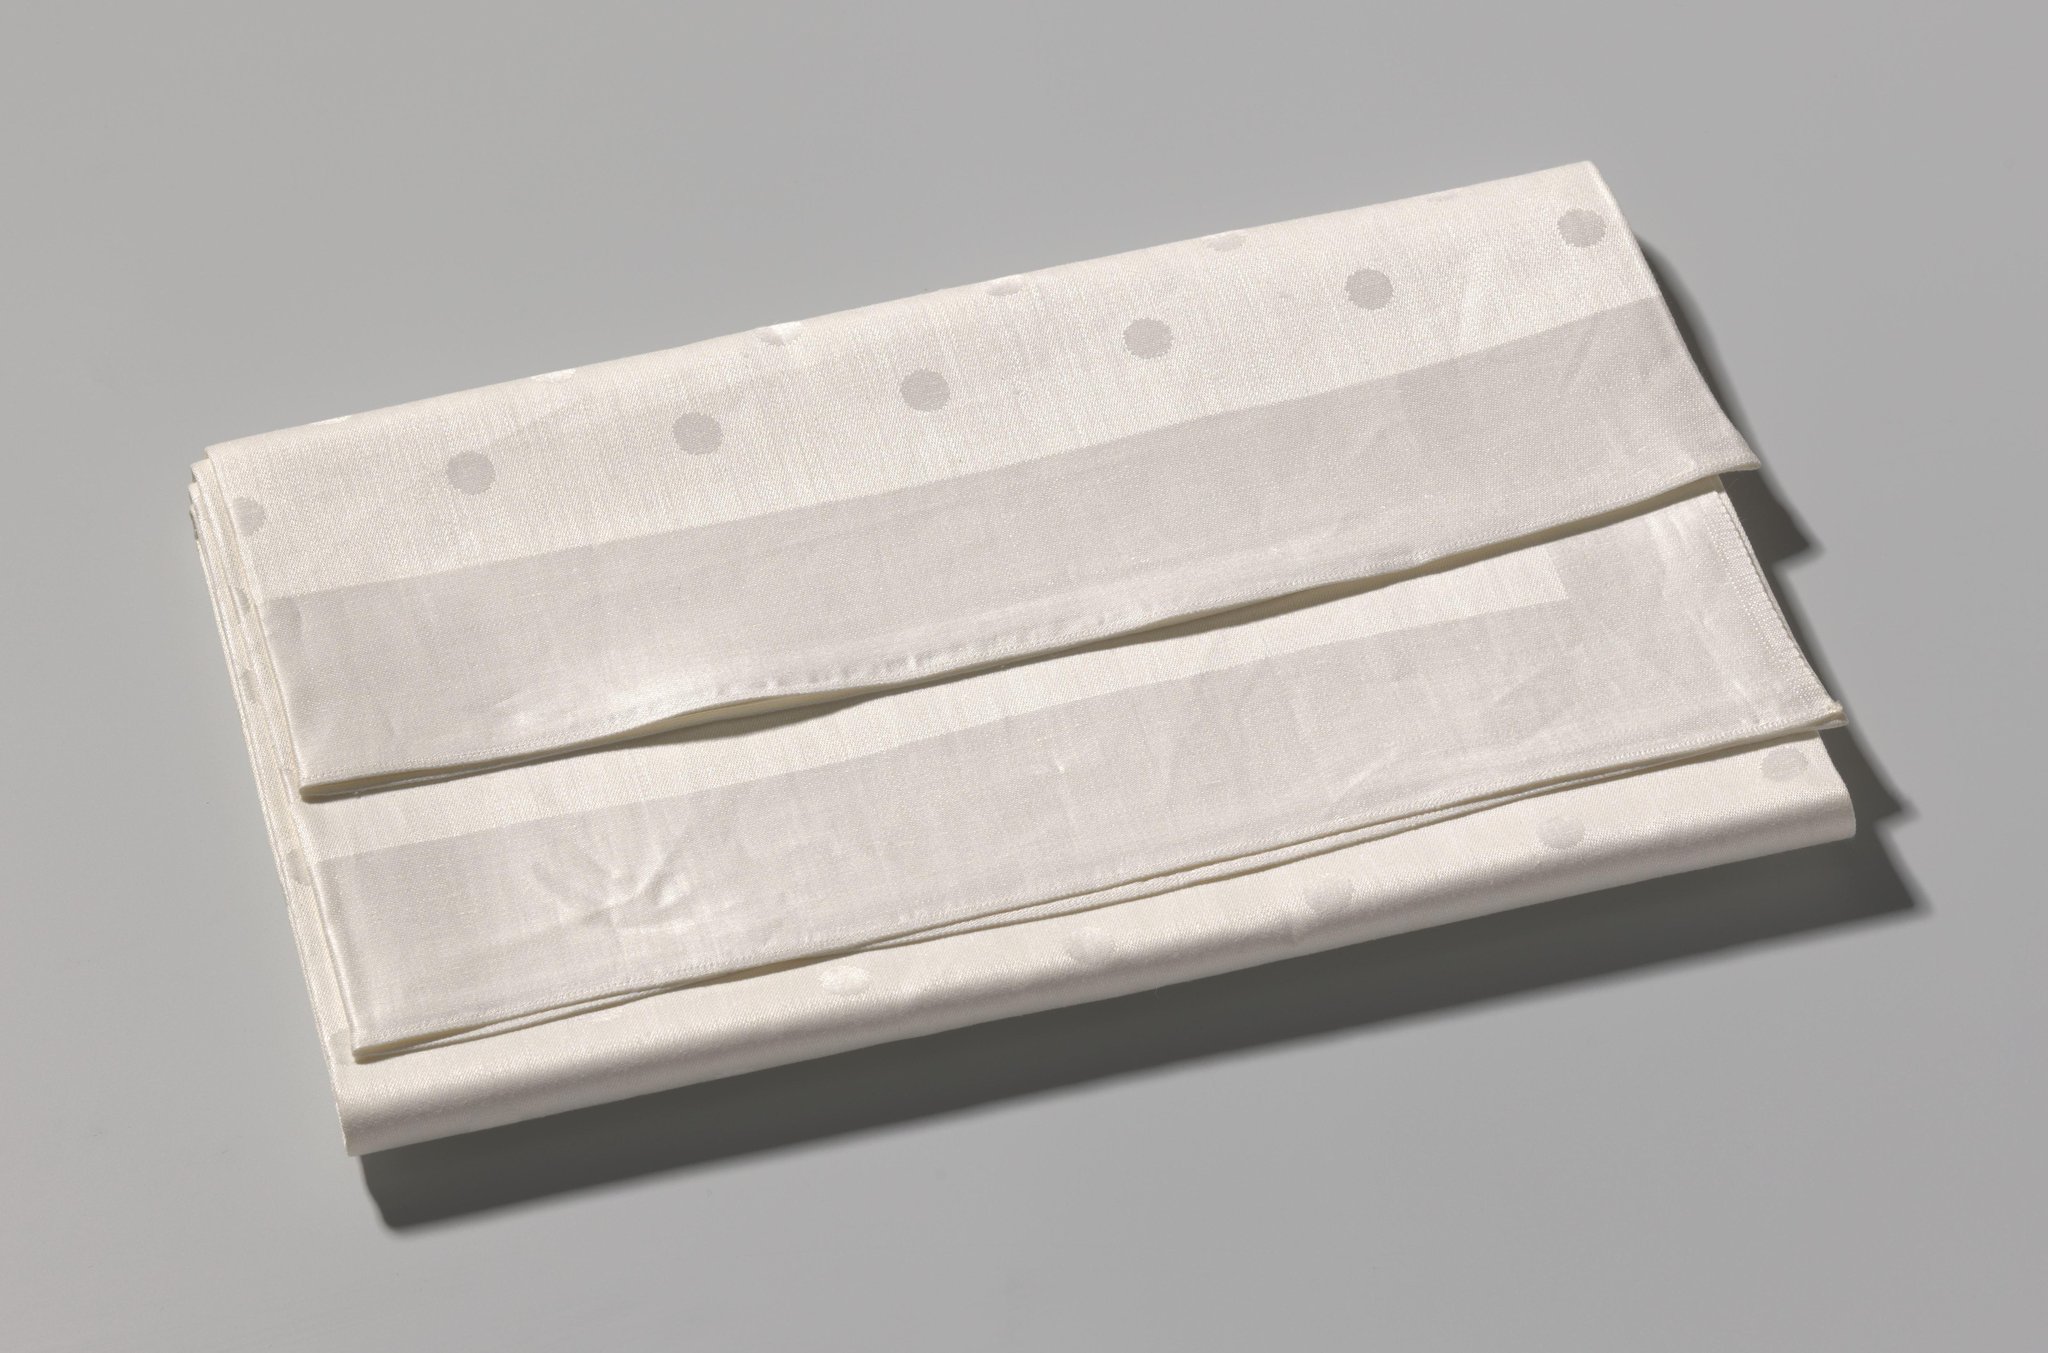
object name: tablecloth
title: Tafellaken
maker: Anonymous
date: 1965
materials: linen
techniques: damask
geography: eindhoven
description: Linnen damasten tafellaken ter herdenking van De Groote Societeit Groningen 1765-1965.